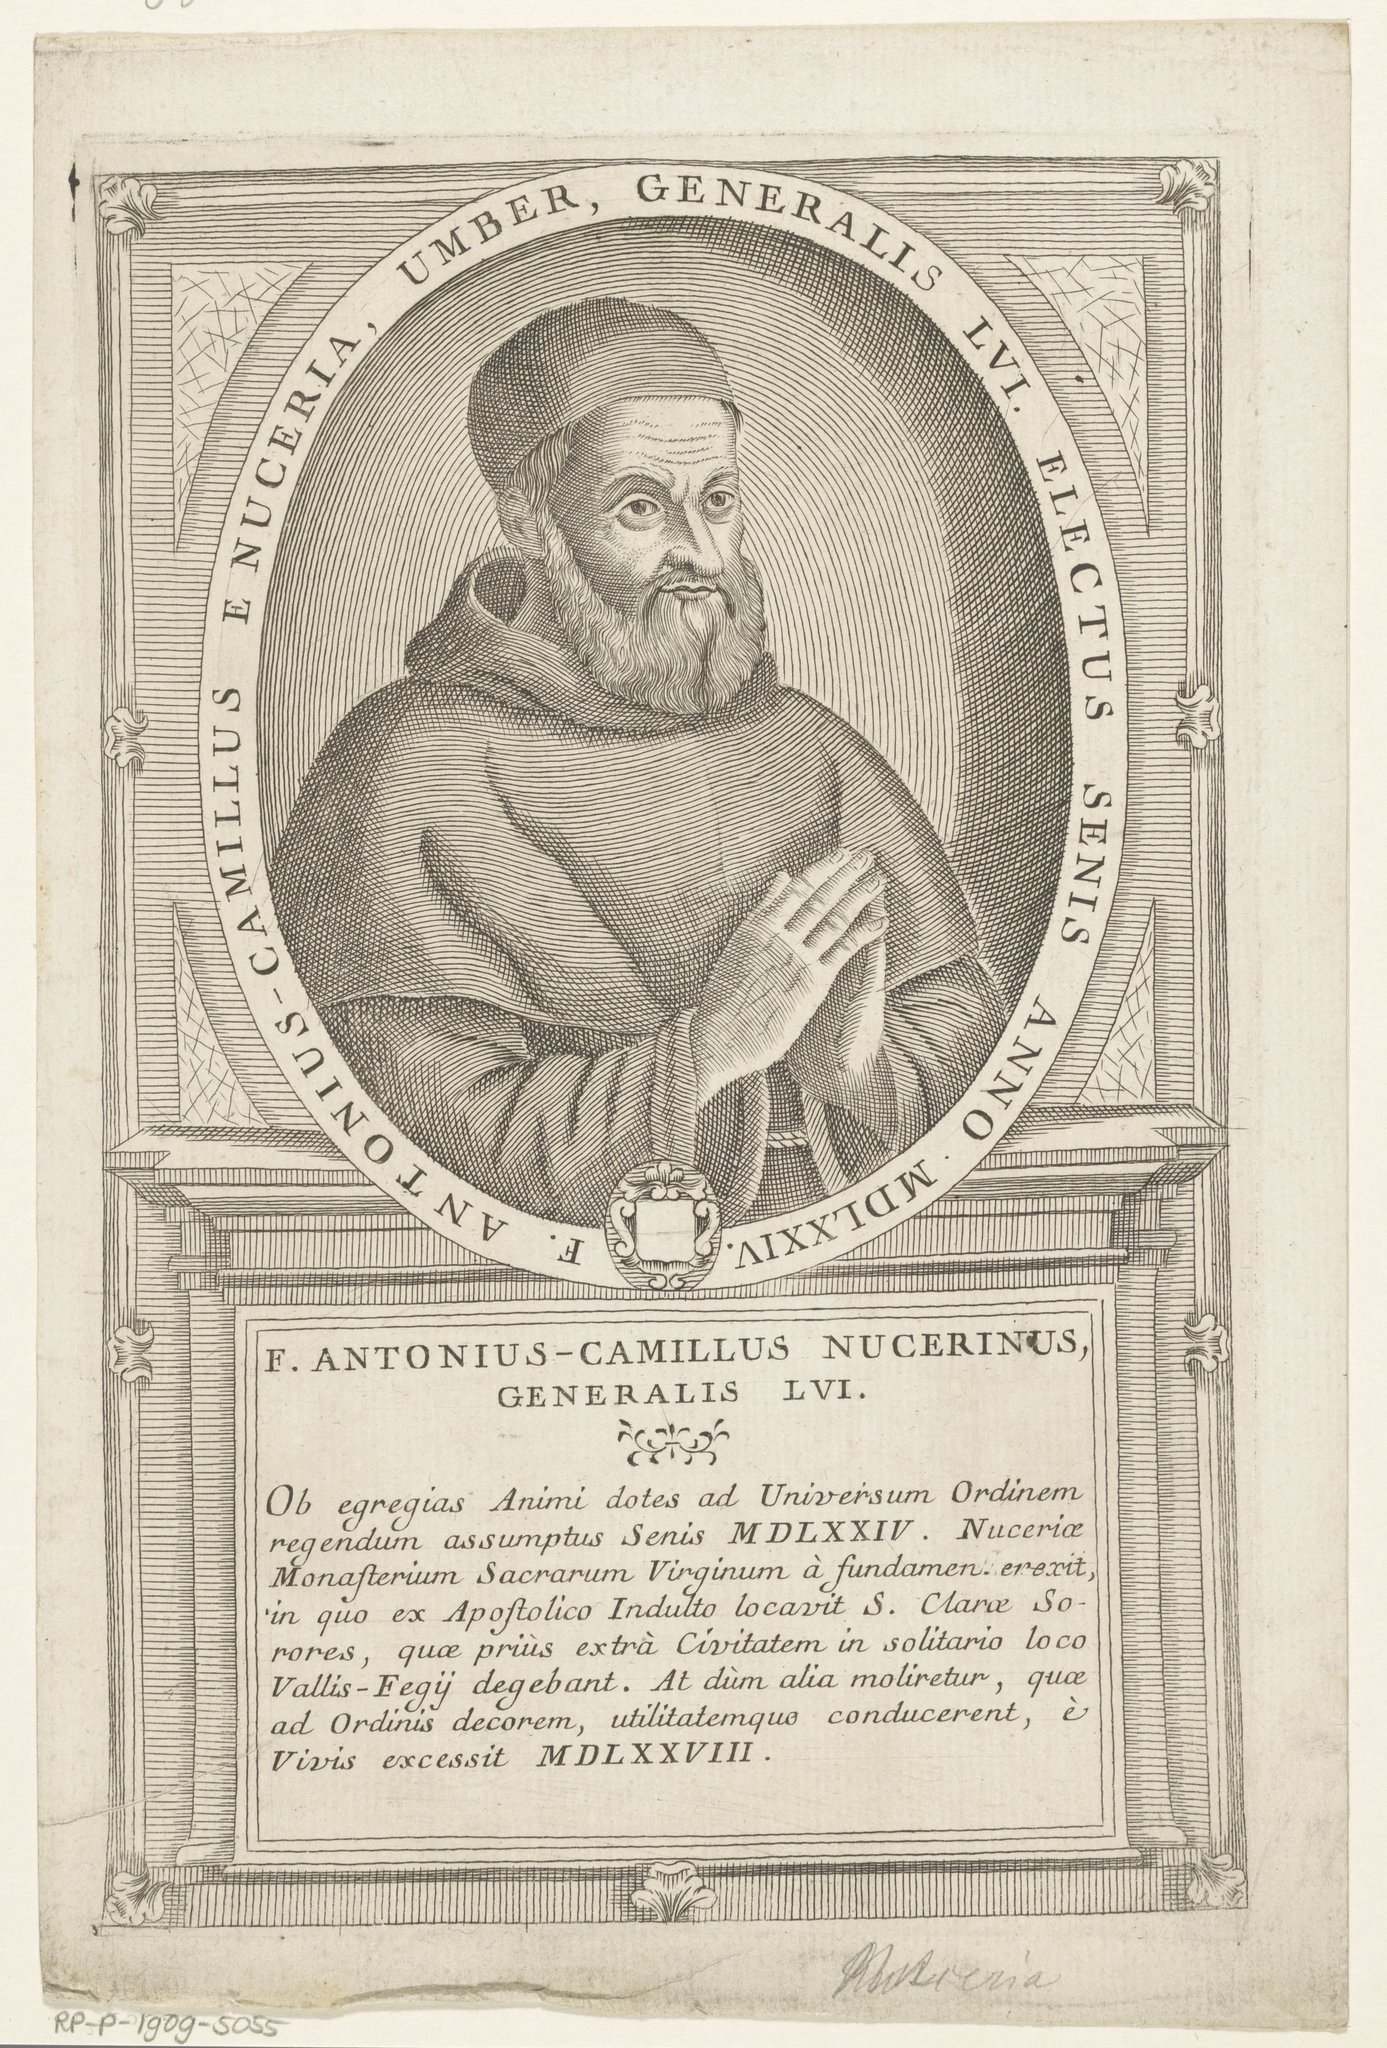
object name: print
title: Portretten van Ministers Generaal van de franciscaner orde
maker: antonio luciani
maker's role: print maker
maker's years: 1700-1738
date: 1710-1738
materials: paper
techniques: engraving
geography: italy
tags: clergyman, historical persons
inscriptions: collector's mark: Lugt 2228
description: Deze prent maakt deel uit van een groep van 60 portretten.